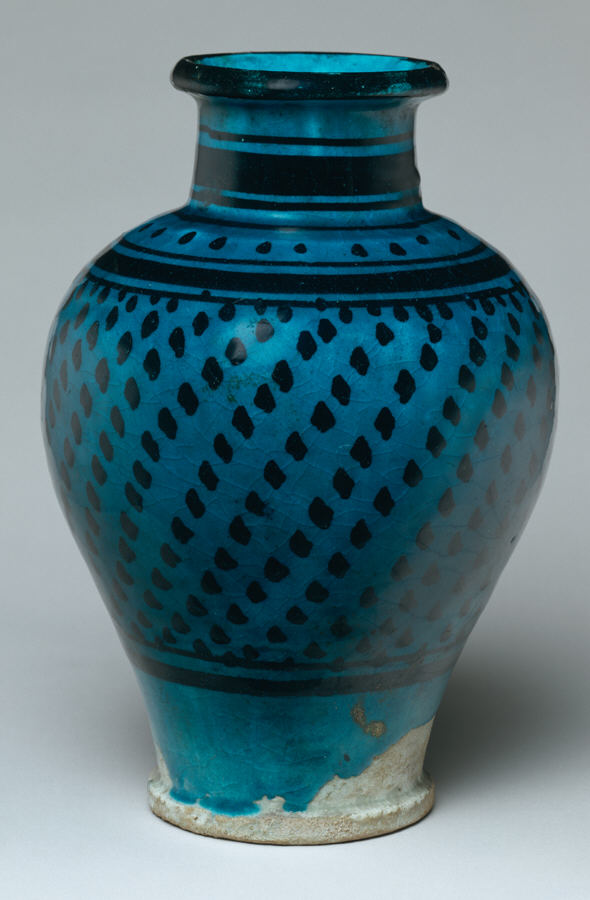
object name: jar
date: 1167-1233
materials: glaze, stonepaste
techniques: painting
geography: syria